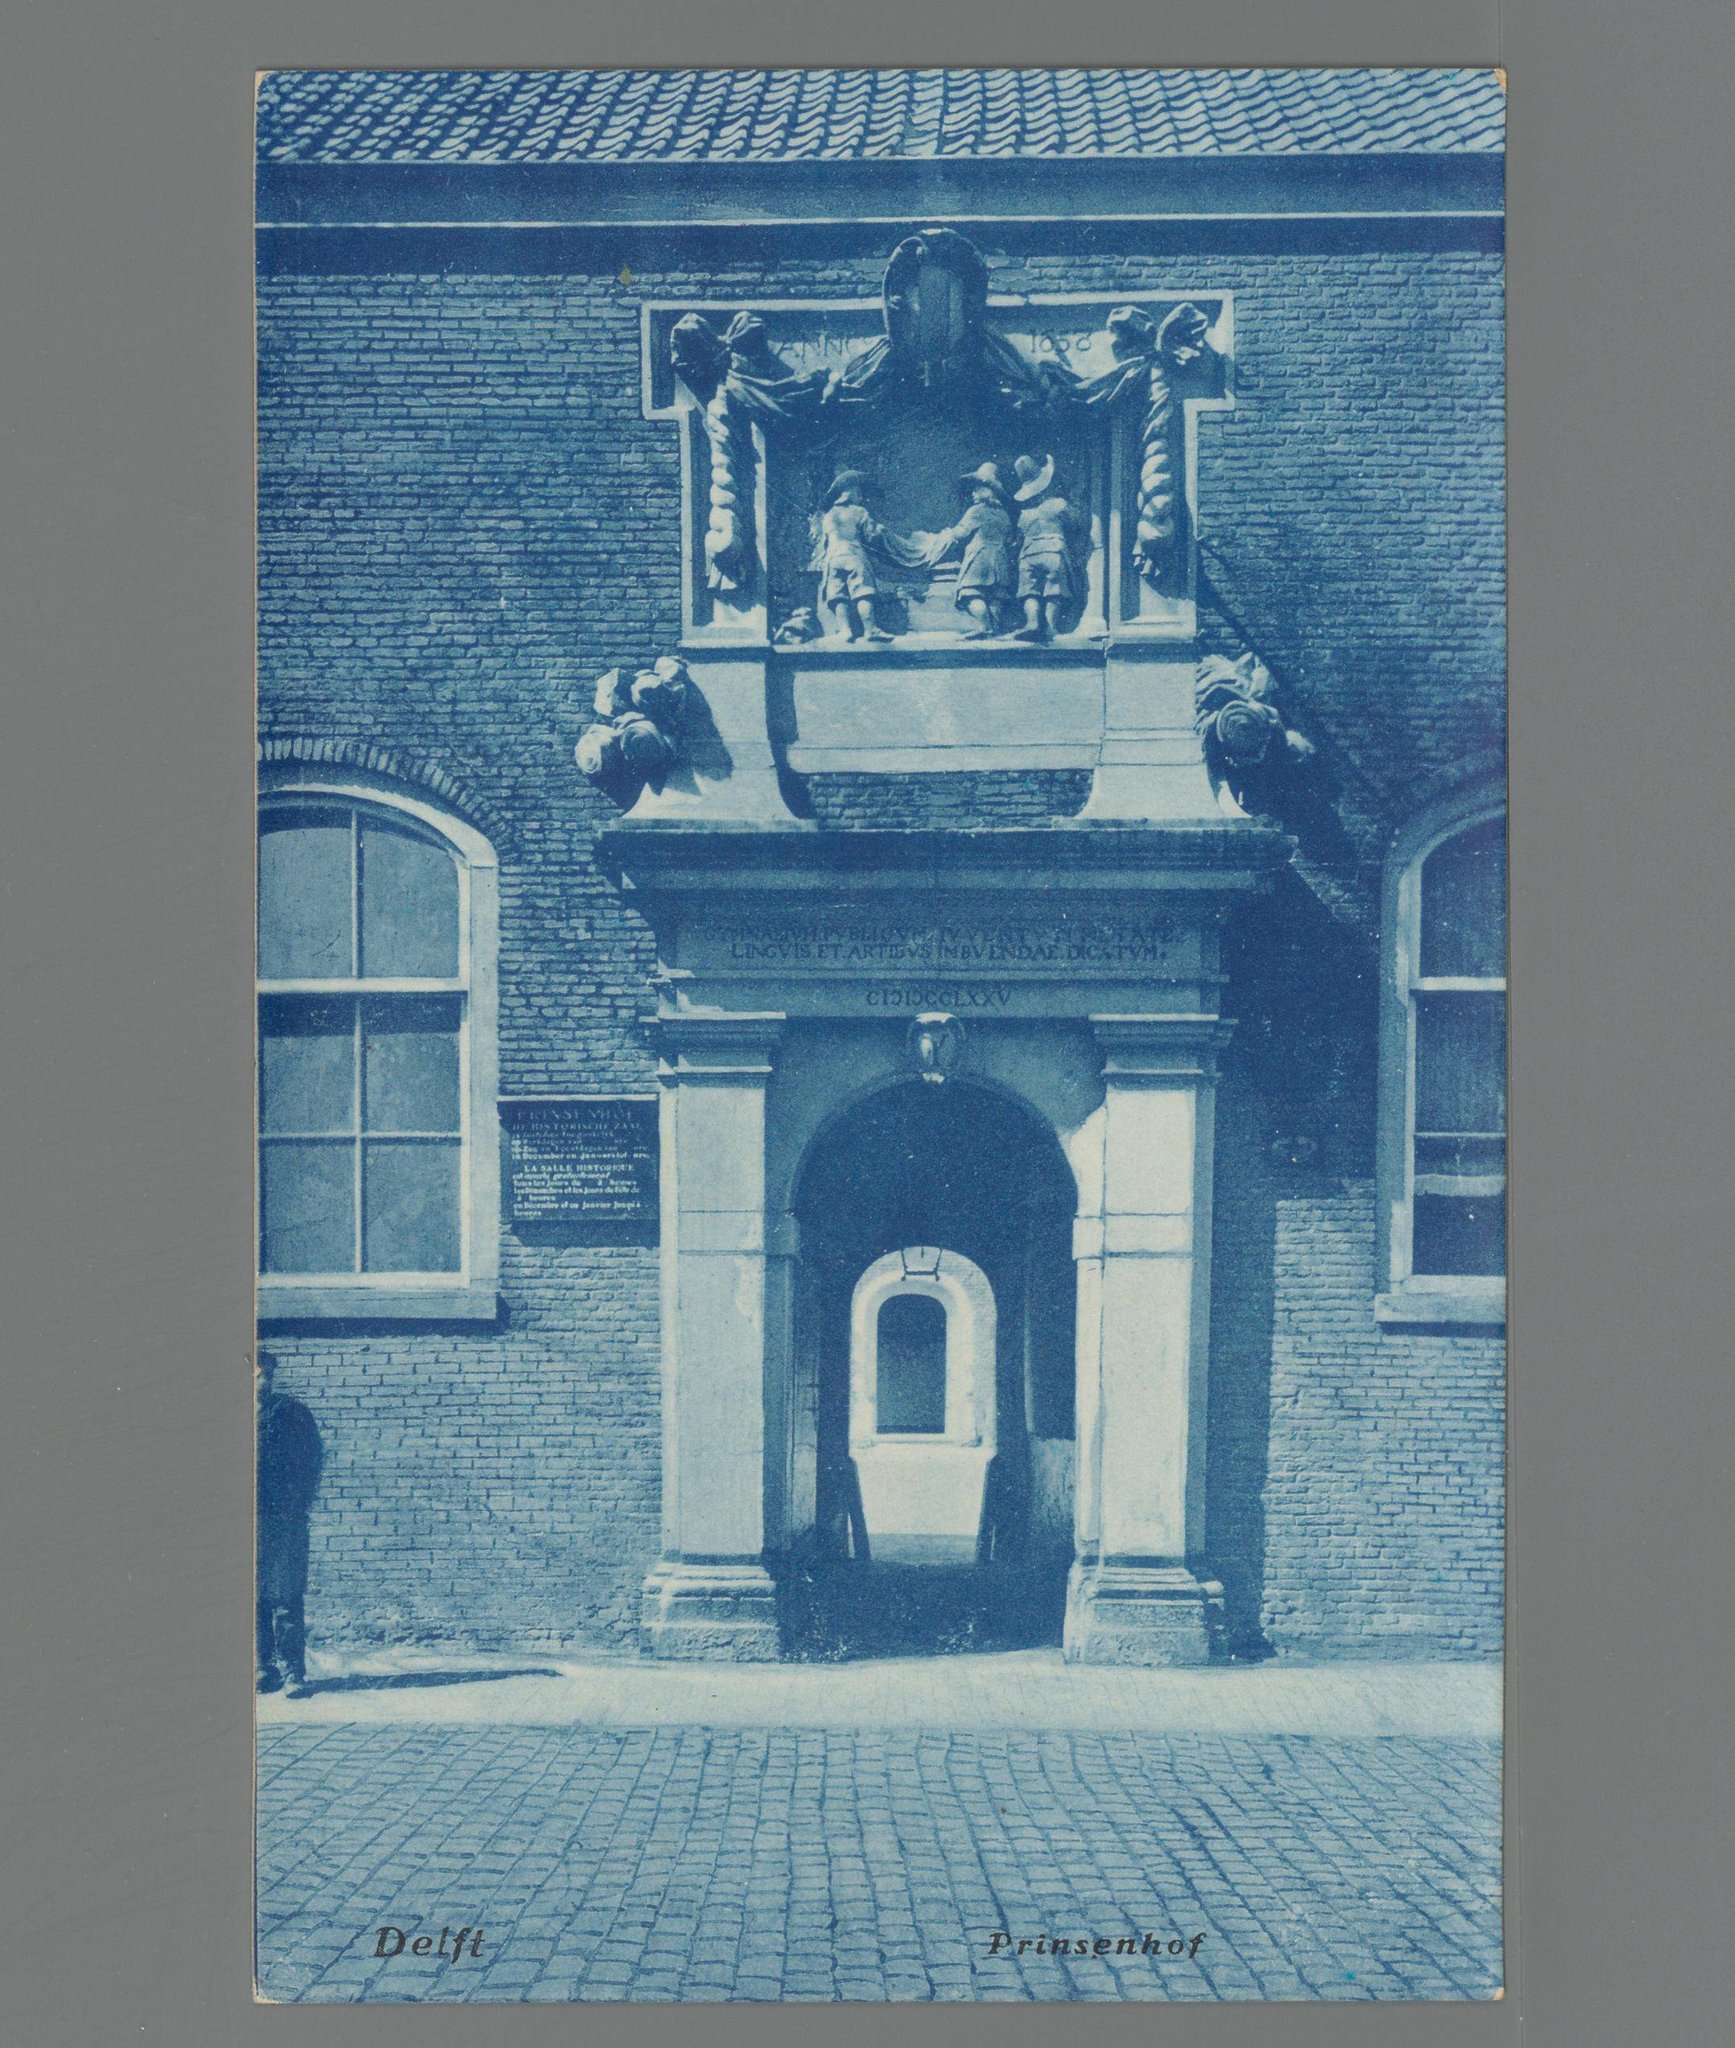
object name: photomechanical print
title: Delft. Prinsenhof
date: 1909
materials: cardboard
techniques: photograph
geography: delft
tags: gate, entrance, permanent exhibition, museum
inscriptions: date